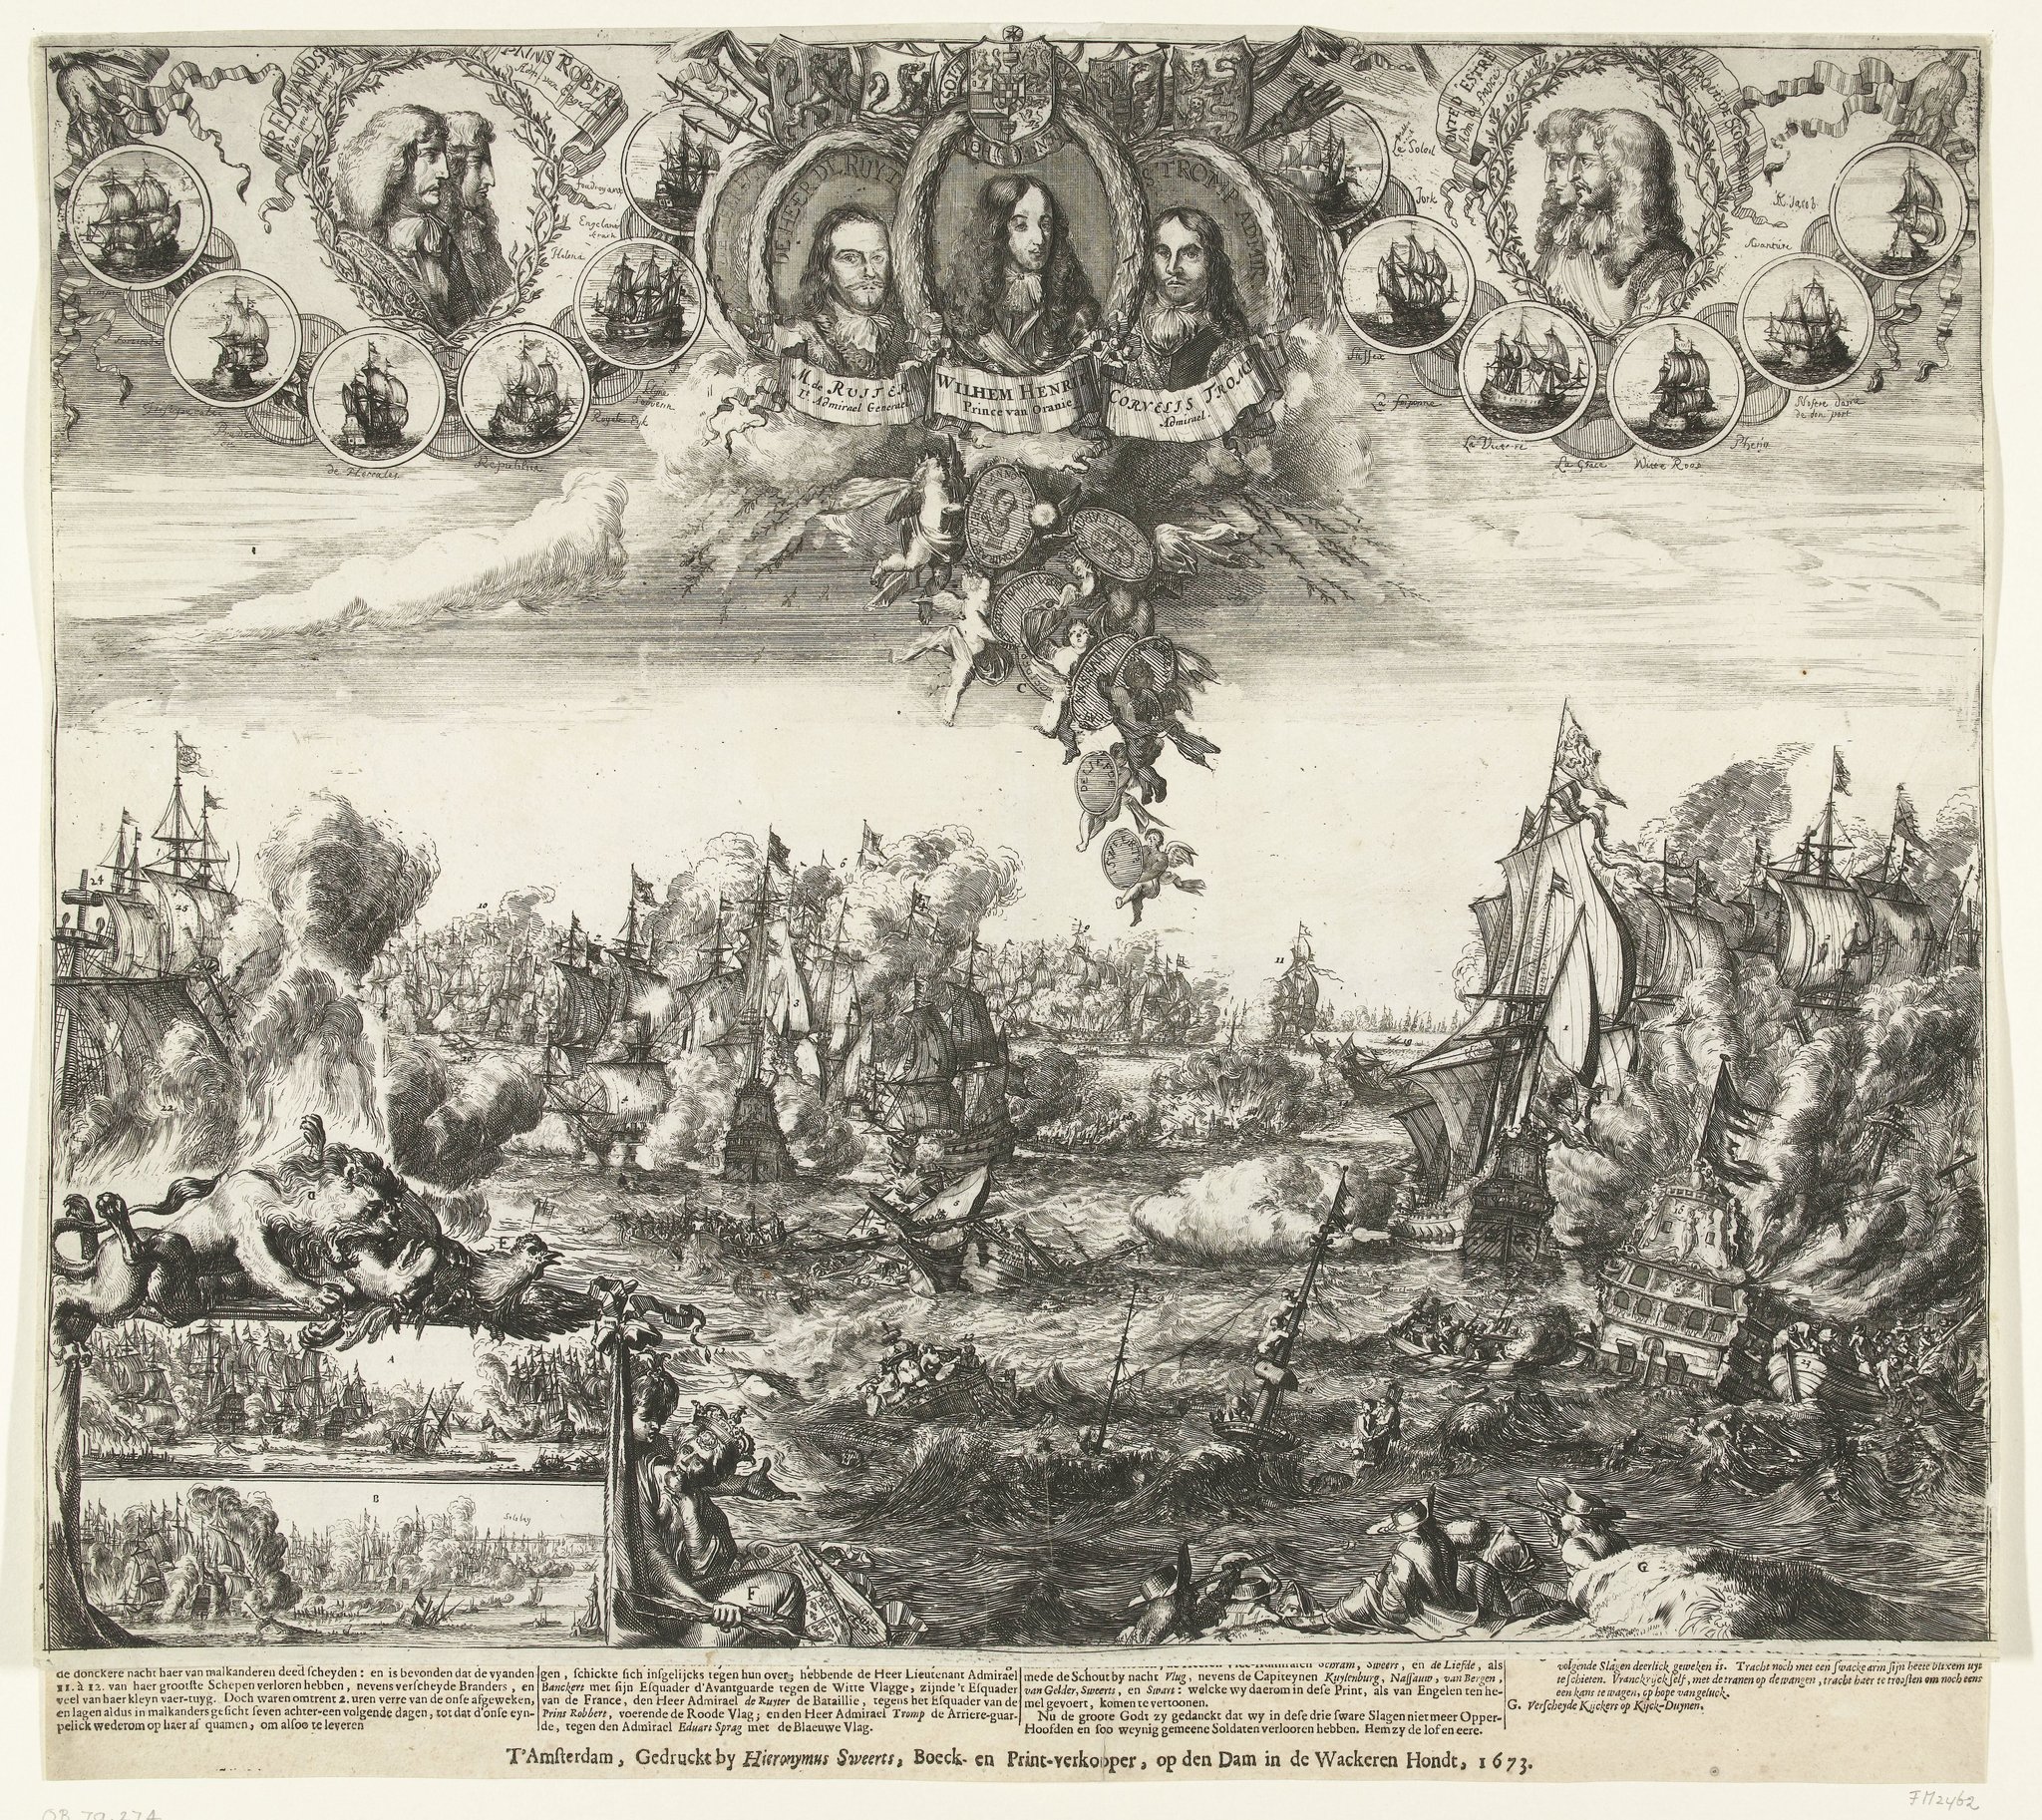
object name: print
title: Pertinente Af-beelding en Naukeurige Beschrijvinge van de Drie Victorieuse Zee-slagen van 't Jaar 1673. Voorgevallen tusschen de Nederlandtsche, Engelsche, en Fransche Vlooten.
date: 1673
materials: paper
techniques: engraving, etching, letterpress printing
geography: amsterdam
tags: prague, london, print maker, draughtsman, prinz ruprecht, flushing, michiel adriaenszoon de ruyter, rotterdam, amsterdam, cornelis tromp, the hague, william iii (prince of orange and king of england, scotland, and ireland), battle (+ naval force), first battle of schooneveld, second battle of schooneveld, battle of the texel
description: Drie zeeslagen uit de Derde Engelse Oorlog, 1673. Linksonder in een cartouche in het klein de eerste twee zeeslagen voor de Zeeuwse kust op de vlakte van Schoonevelt op 7 juni en 14 juni. De hoofdvoorstelling toont de slag bij Kijkduin op 21 augustus tussen de vloot van de Republiek onder Michiel Adriaenszoon de Ruyter en de gecombineerde Engels-Franse vloot onder Prins Rupert en graaf Jean d'Estrées. Bovenaan medaillons met portretten van Willem III, Michiel Adriaenszoon de Ruyter en Cornelis Tromp. Linksboven portretten van de twee Engelse bevelhebbers en hun belangrijkste schepen, rechts de Fransen met hun schepen. Bij de prent een tekstblad met de titel en een beschrijving van de gebeurtenissen en een legenda 1-24 en A-G in 4 kolommen in het Nederlands